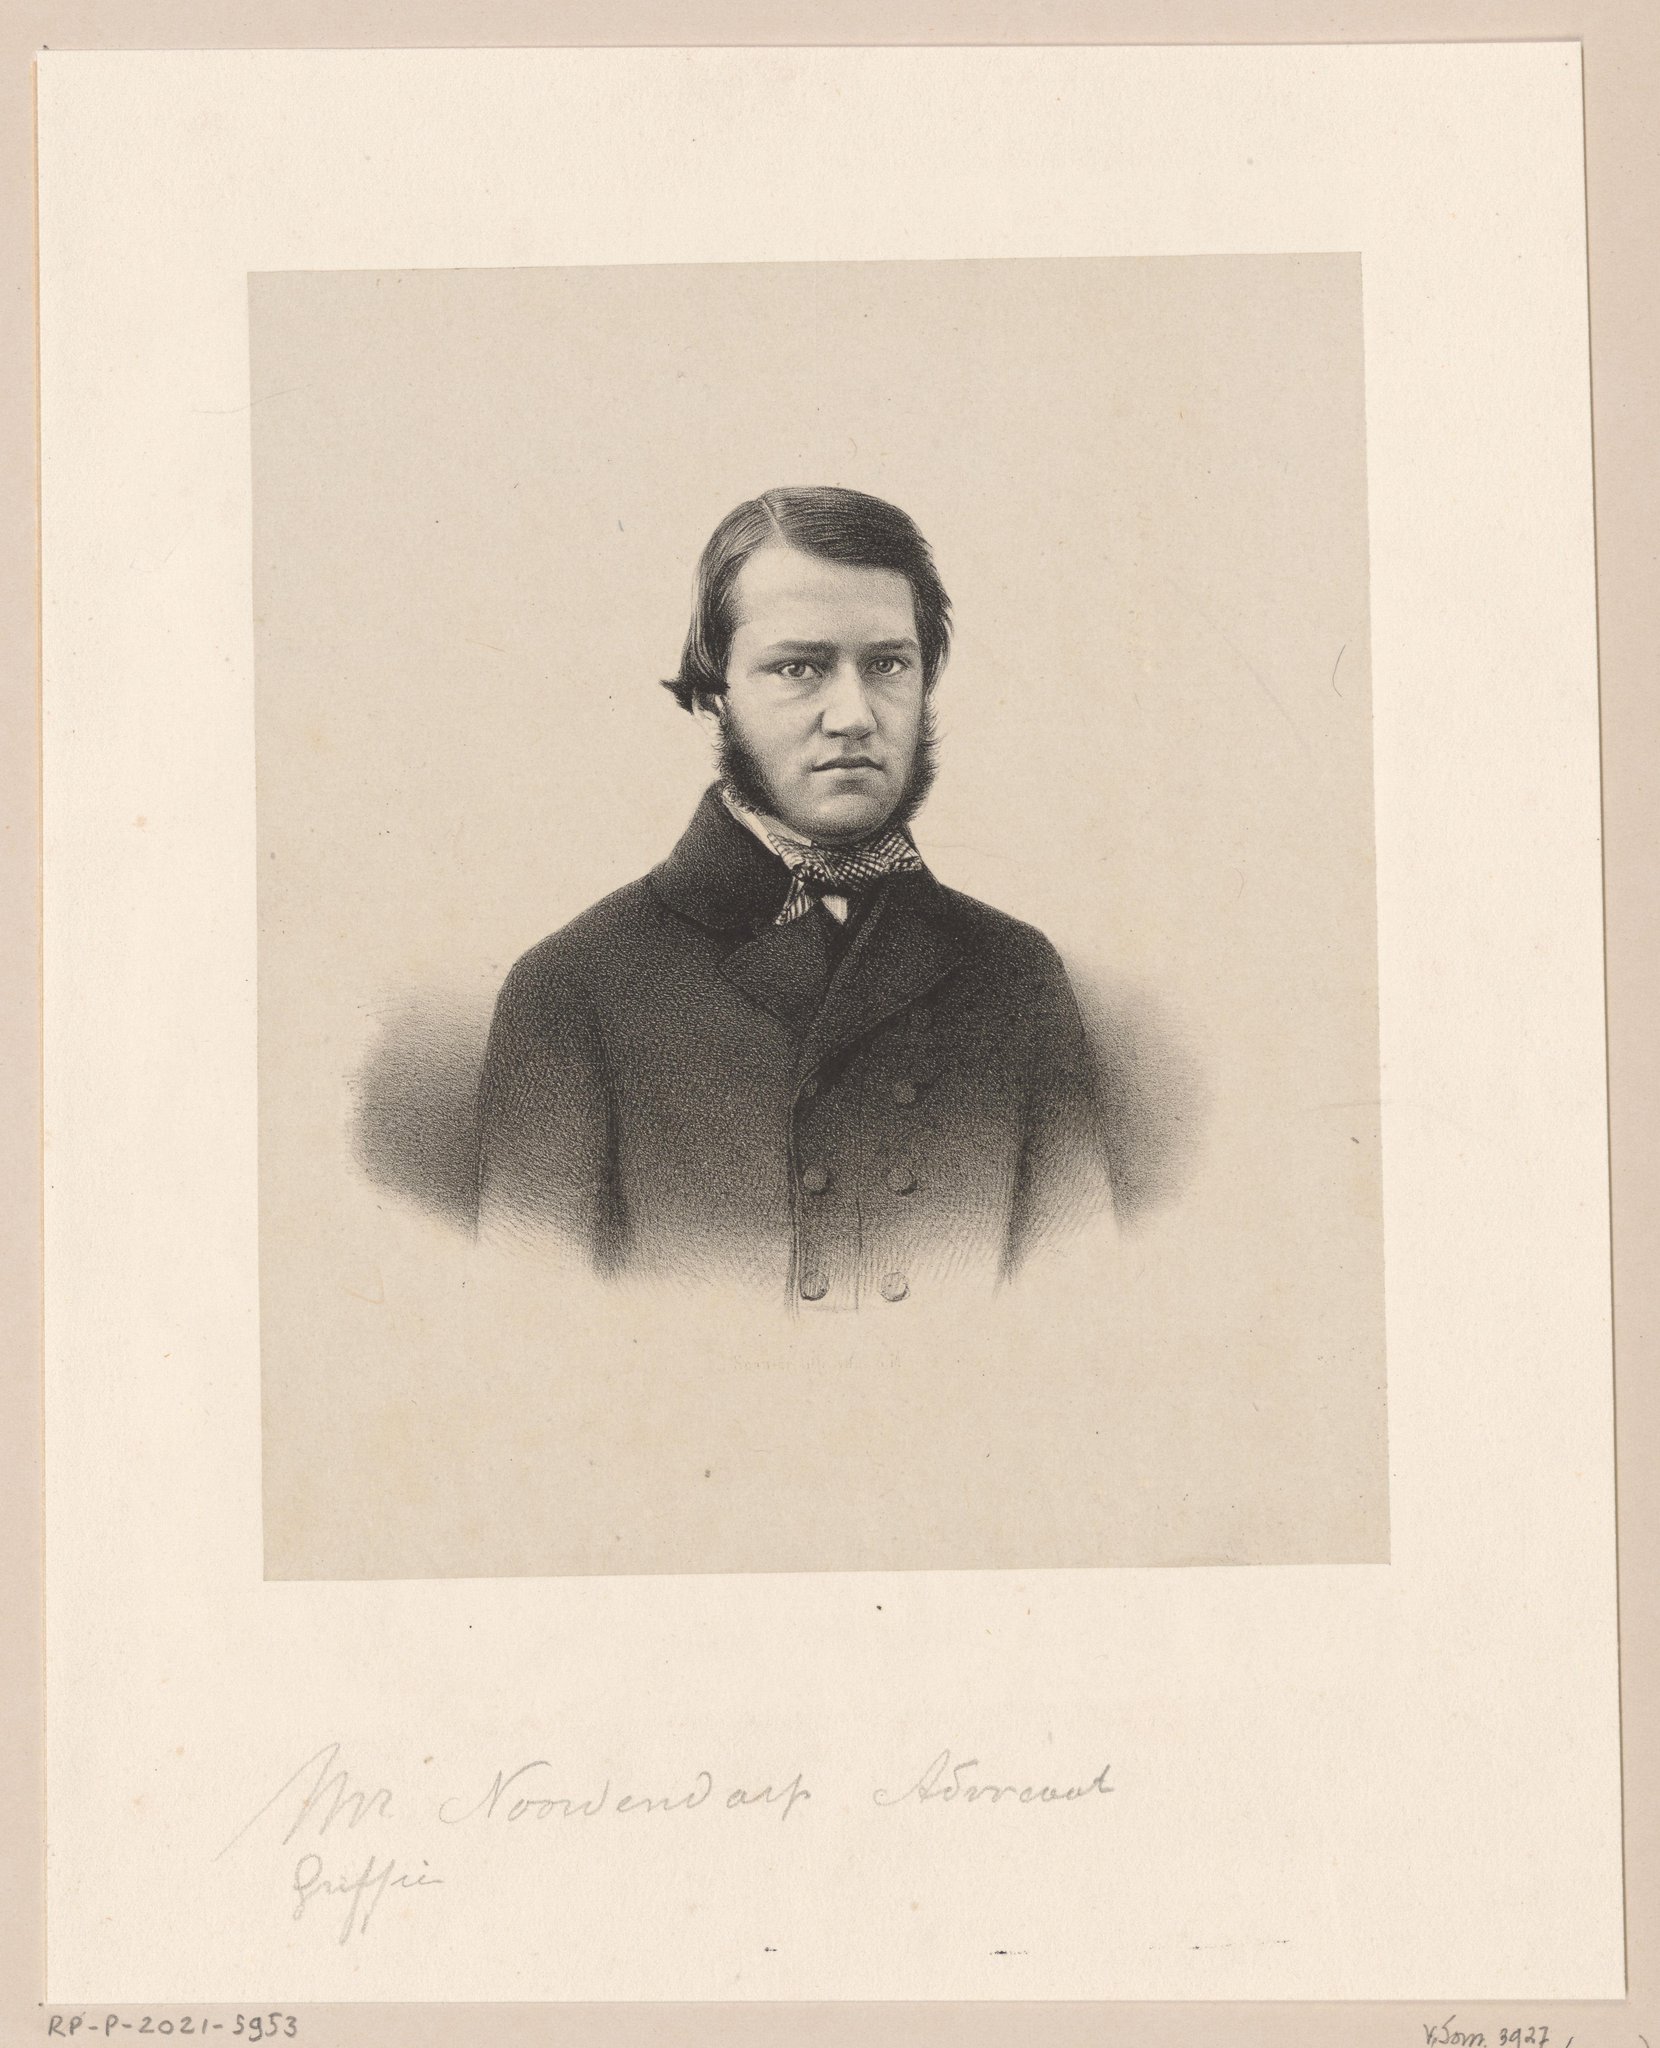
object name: print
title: Portret van J.B. Noordendorp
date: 1843-1863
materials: paper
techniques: lithograph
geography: the hague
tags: historical persons